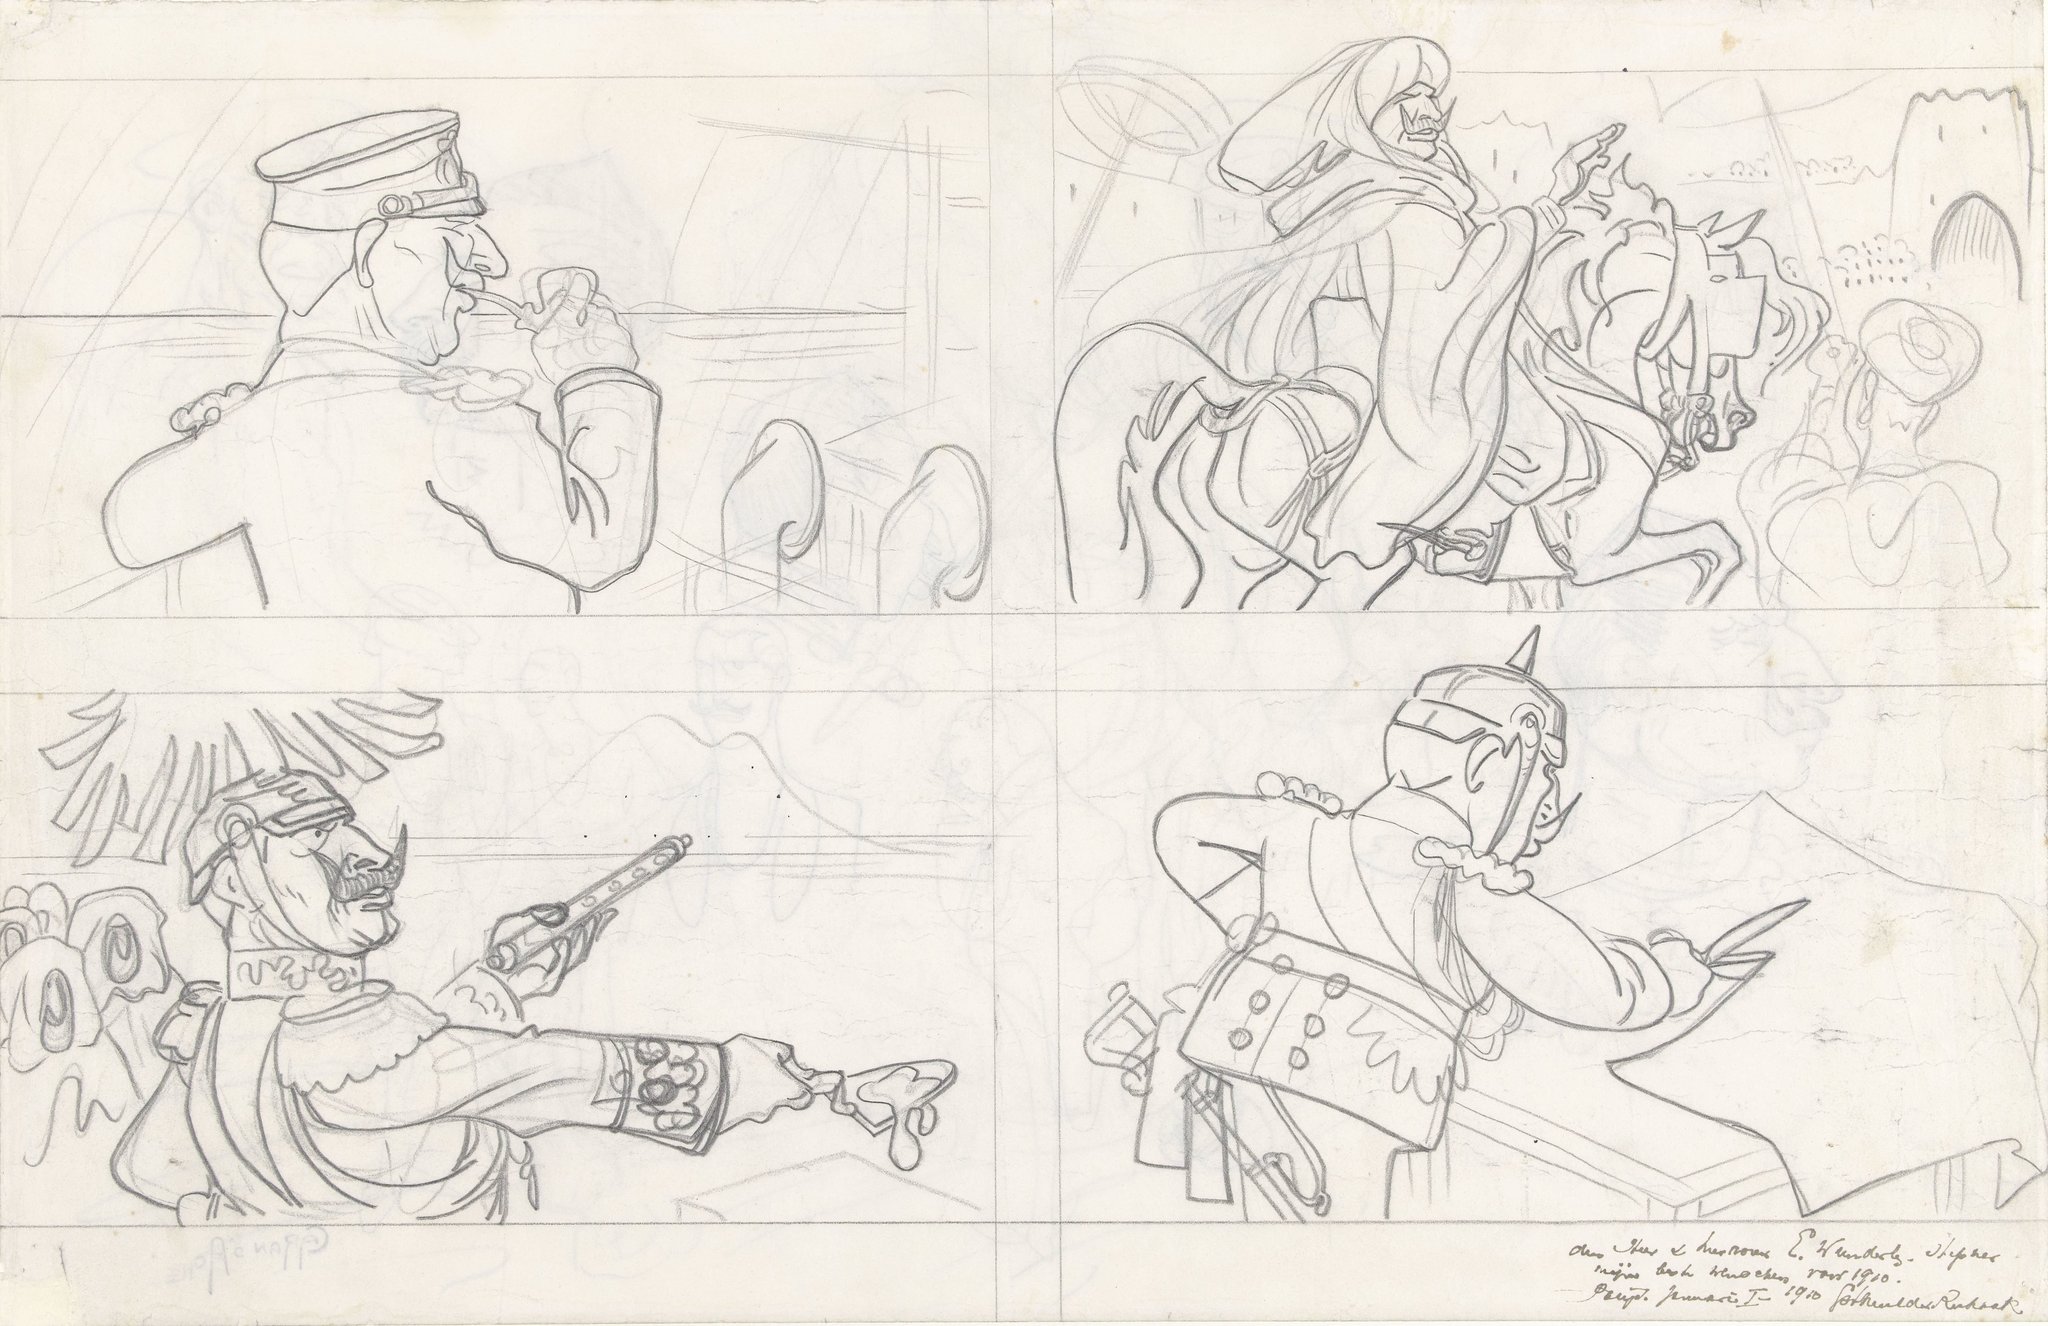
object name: drawing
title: Karikaturen van keizer Wilhelm van Duitsland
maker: caran dache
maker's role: draughtsman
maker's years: 1859-1909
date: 1888-1910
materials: paper, pencil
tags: wilhelm ii (keizer van duitsland), political caricatures and satires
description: Vier karikaturale tekeningen van keizer Wilhelm II. Linksboven Wilhelm pijprokend op een schip, rechtsboven Wilhelm in Arabische dracht te paard, linksonder Wilhelm metselend met een fluit in de hand, rechtsonder Wilhelm die een blad papier (landkaart) in tweeën knipt.